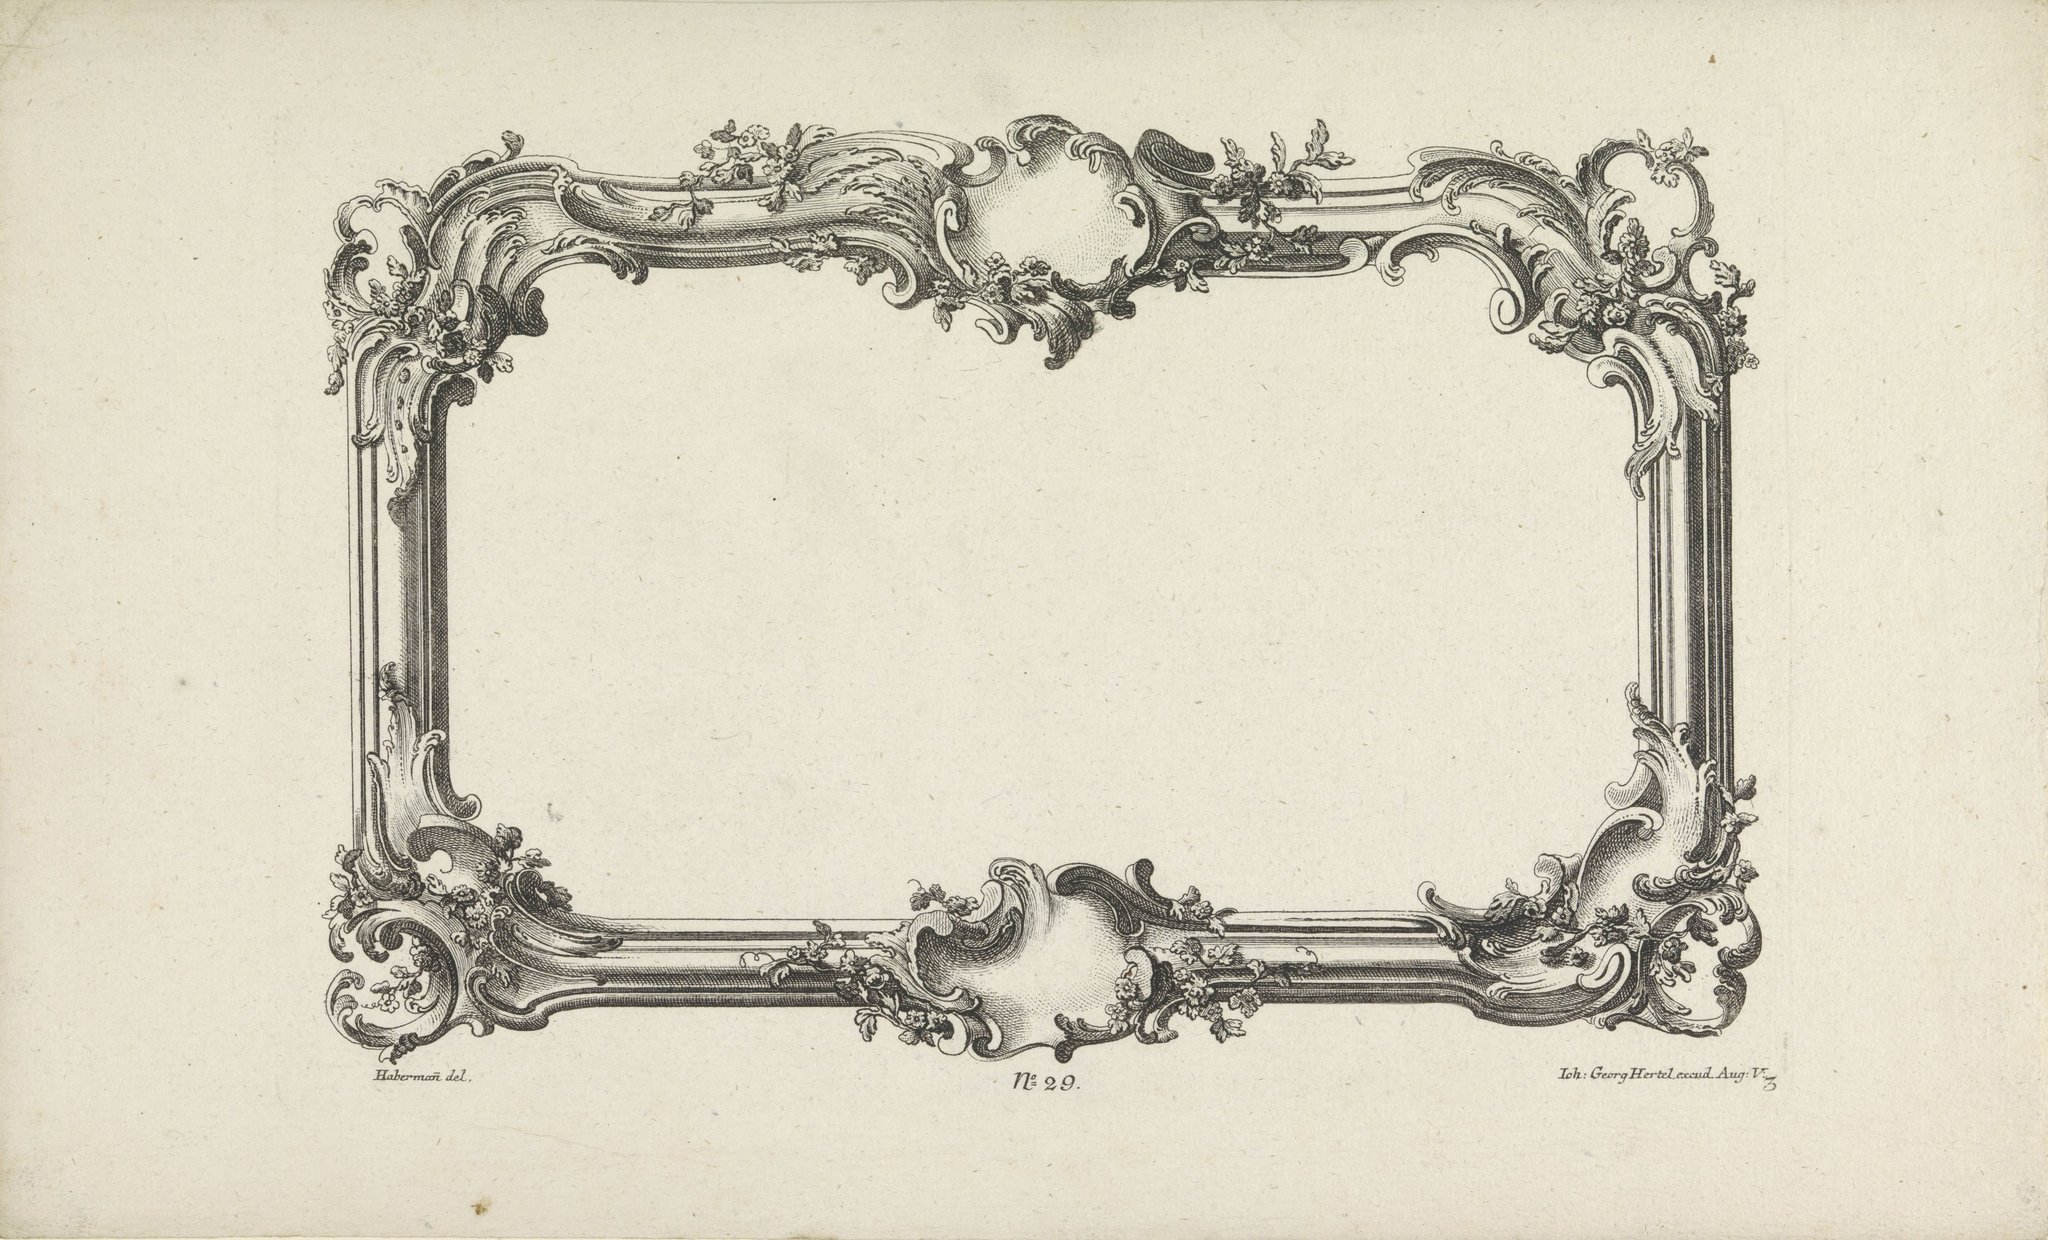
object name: ornament print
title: Rocaille lijst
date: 1731-1775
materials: paper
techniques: etching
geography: augsburg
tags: rocaille ornament, ornaments ~ art (+ framing decorations)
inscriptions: collector's mark: Lugt 2760, collector's mark: Lugt 2228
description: Rocaille omlijsting met bloemen, liggend rechthoek. Uitgeversnummer 29.